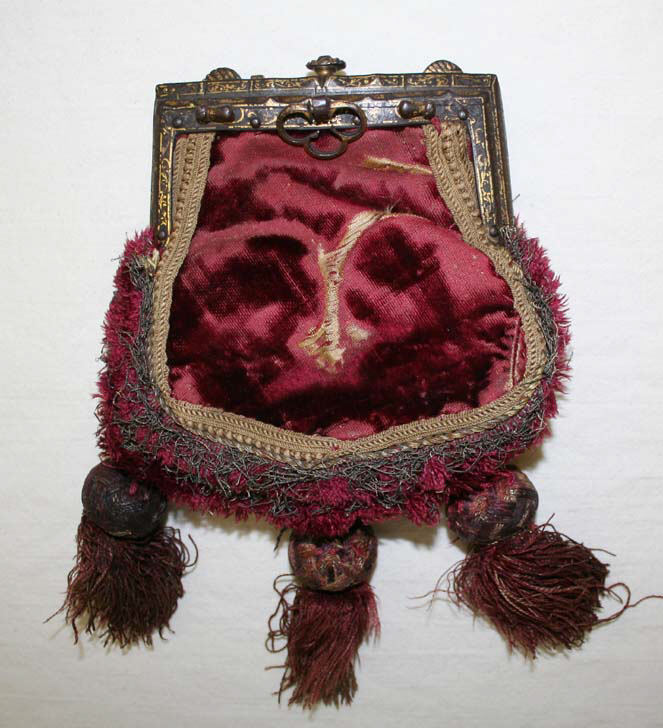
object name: purse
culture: german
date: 1501-1600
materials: metal, silk